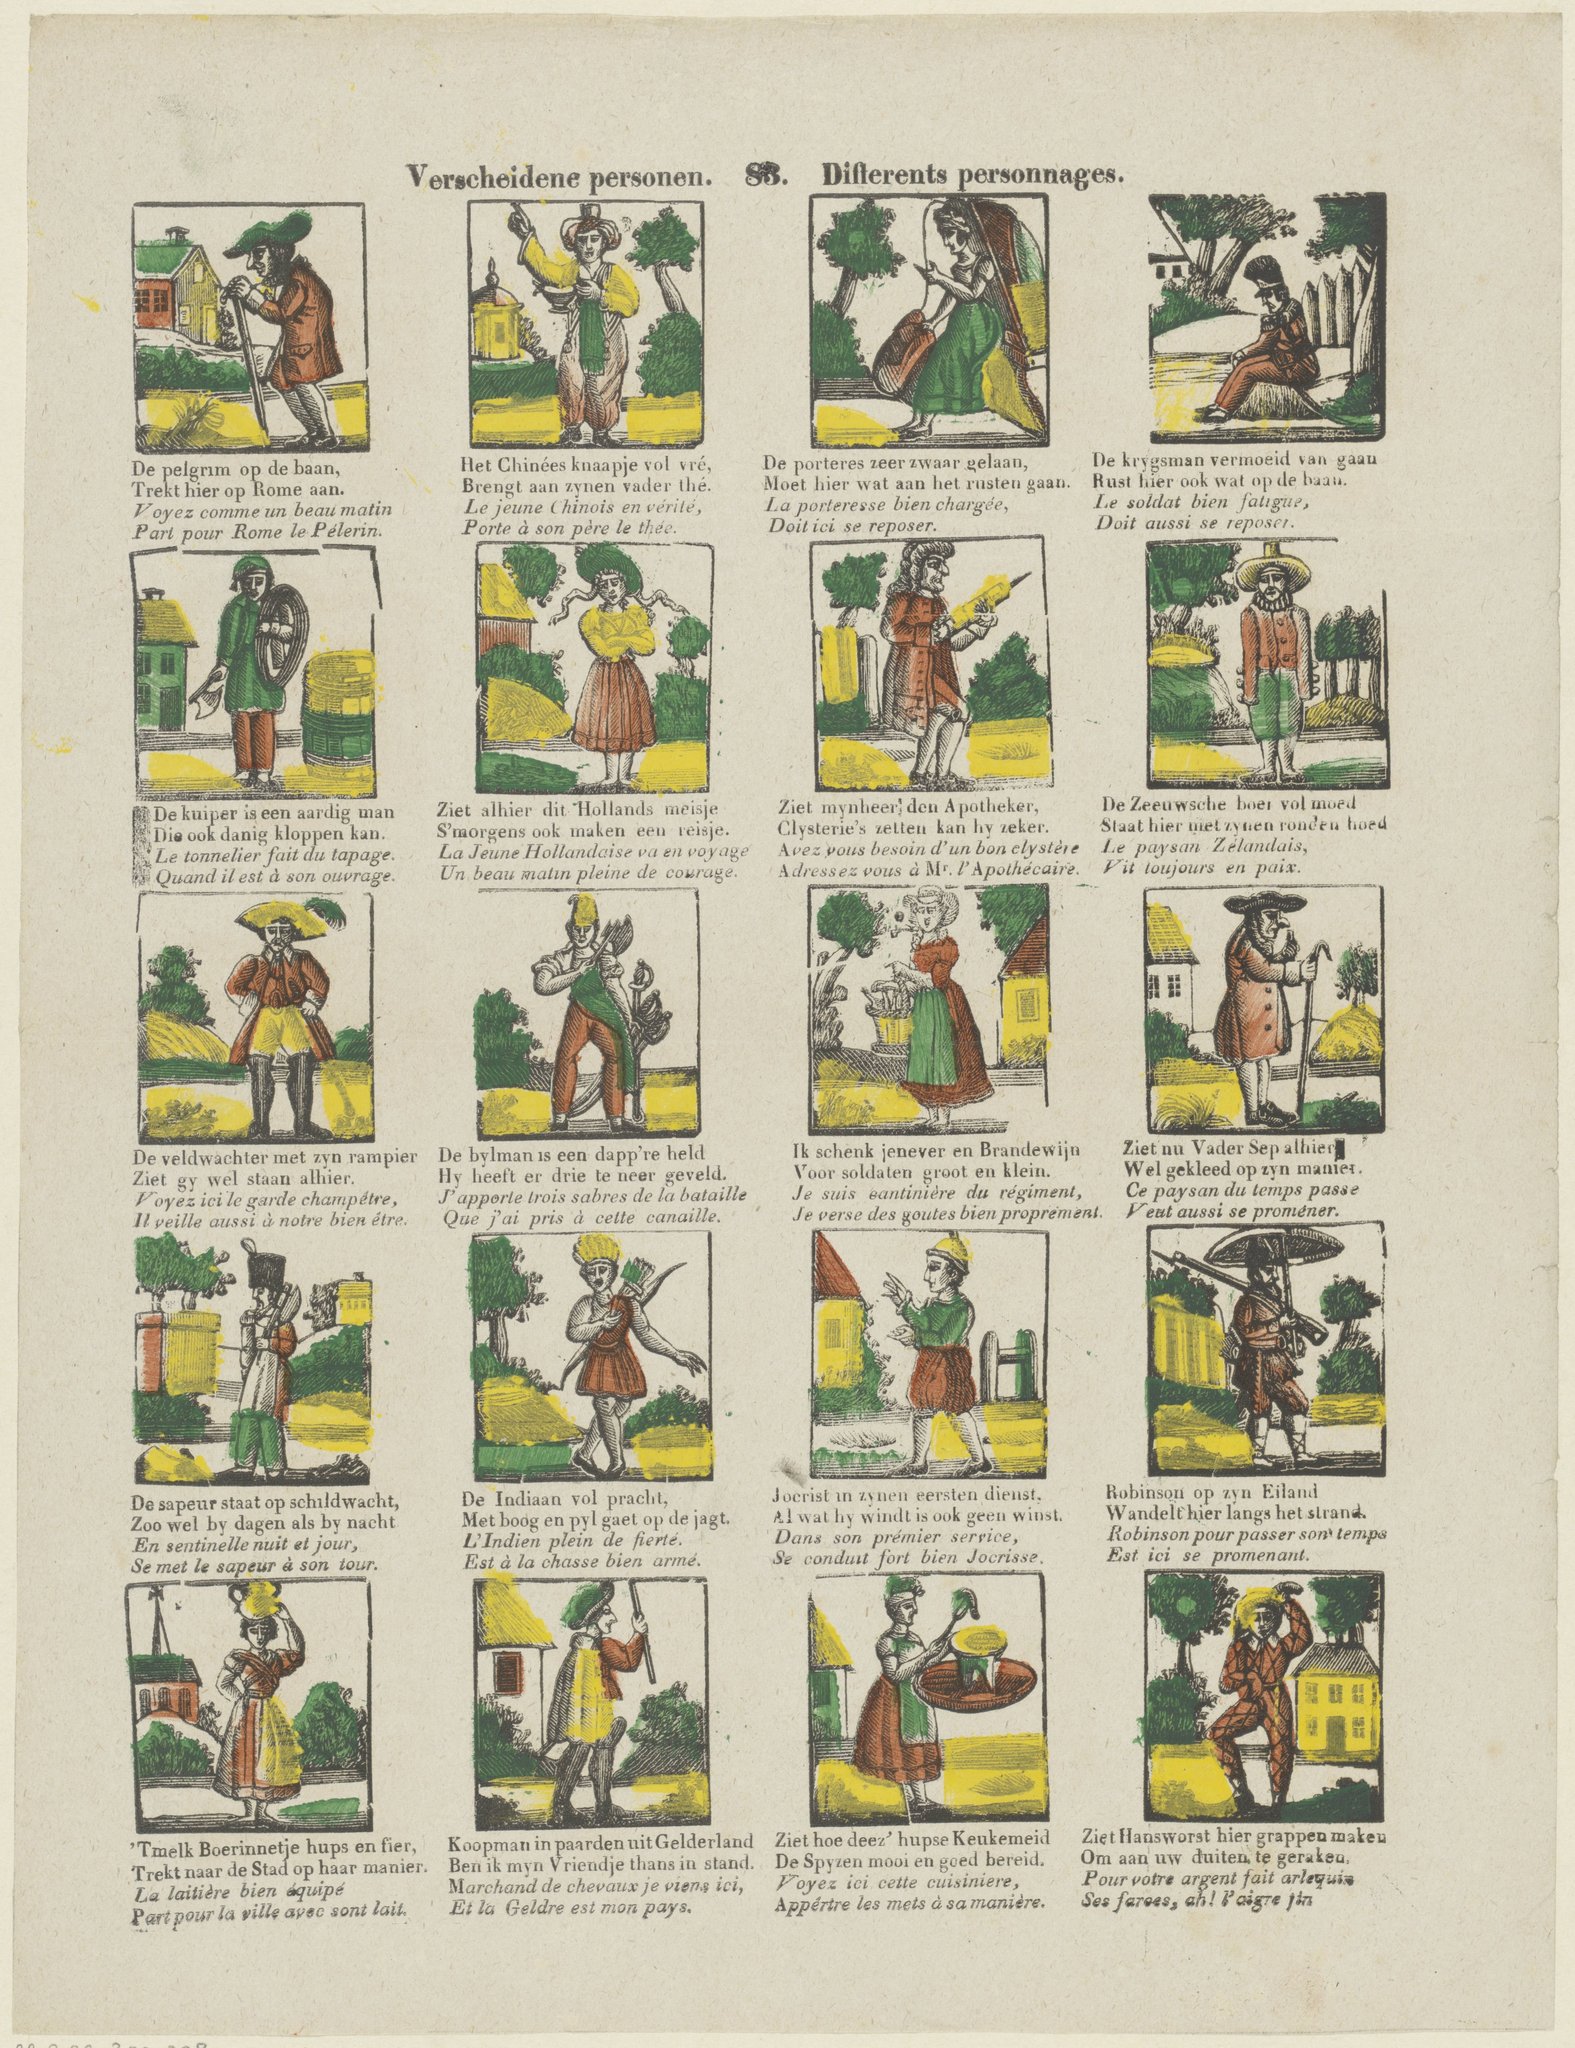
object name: print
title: Verscheidene personen / Differents personnages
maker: Anonymous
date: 1856-1900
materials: paper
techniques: colour, letterpress printing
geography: turnhout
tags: pharmacist, druggist, apothecary; pharmacy, drugstore, dispensing chemist, indigenous peoples of north america, characters (human types)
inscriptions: collector's mark: Lugt 2760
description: Blad met twintig voorstellingen van verschillende figuren, zoals een kuiper, een apotheker en een oorspronkelijke bewoner van Amerika. Onder elke afbeelding een tweeregelig vers in het Nederlands en in het Frans. Genummerd midden boven: 83.